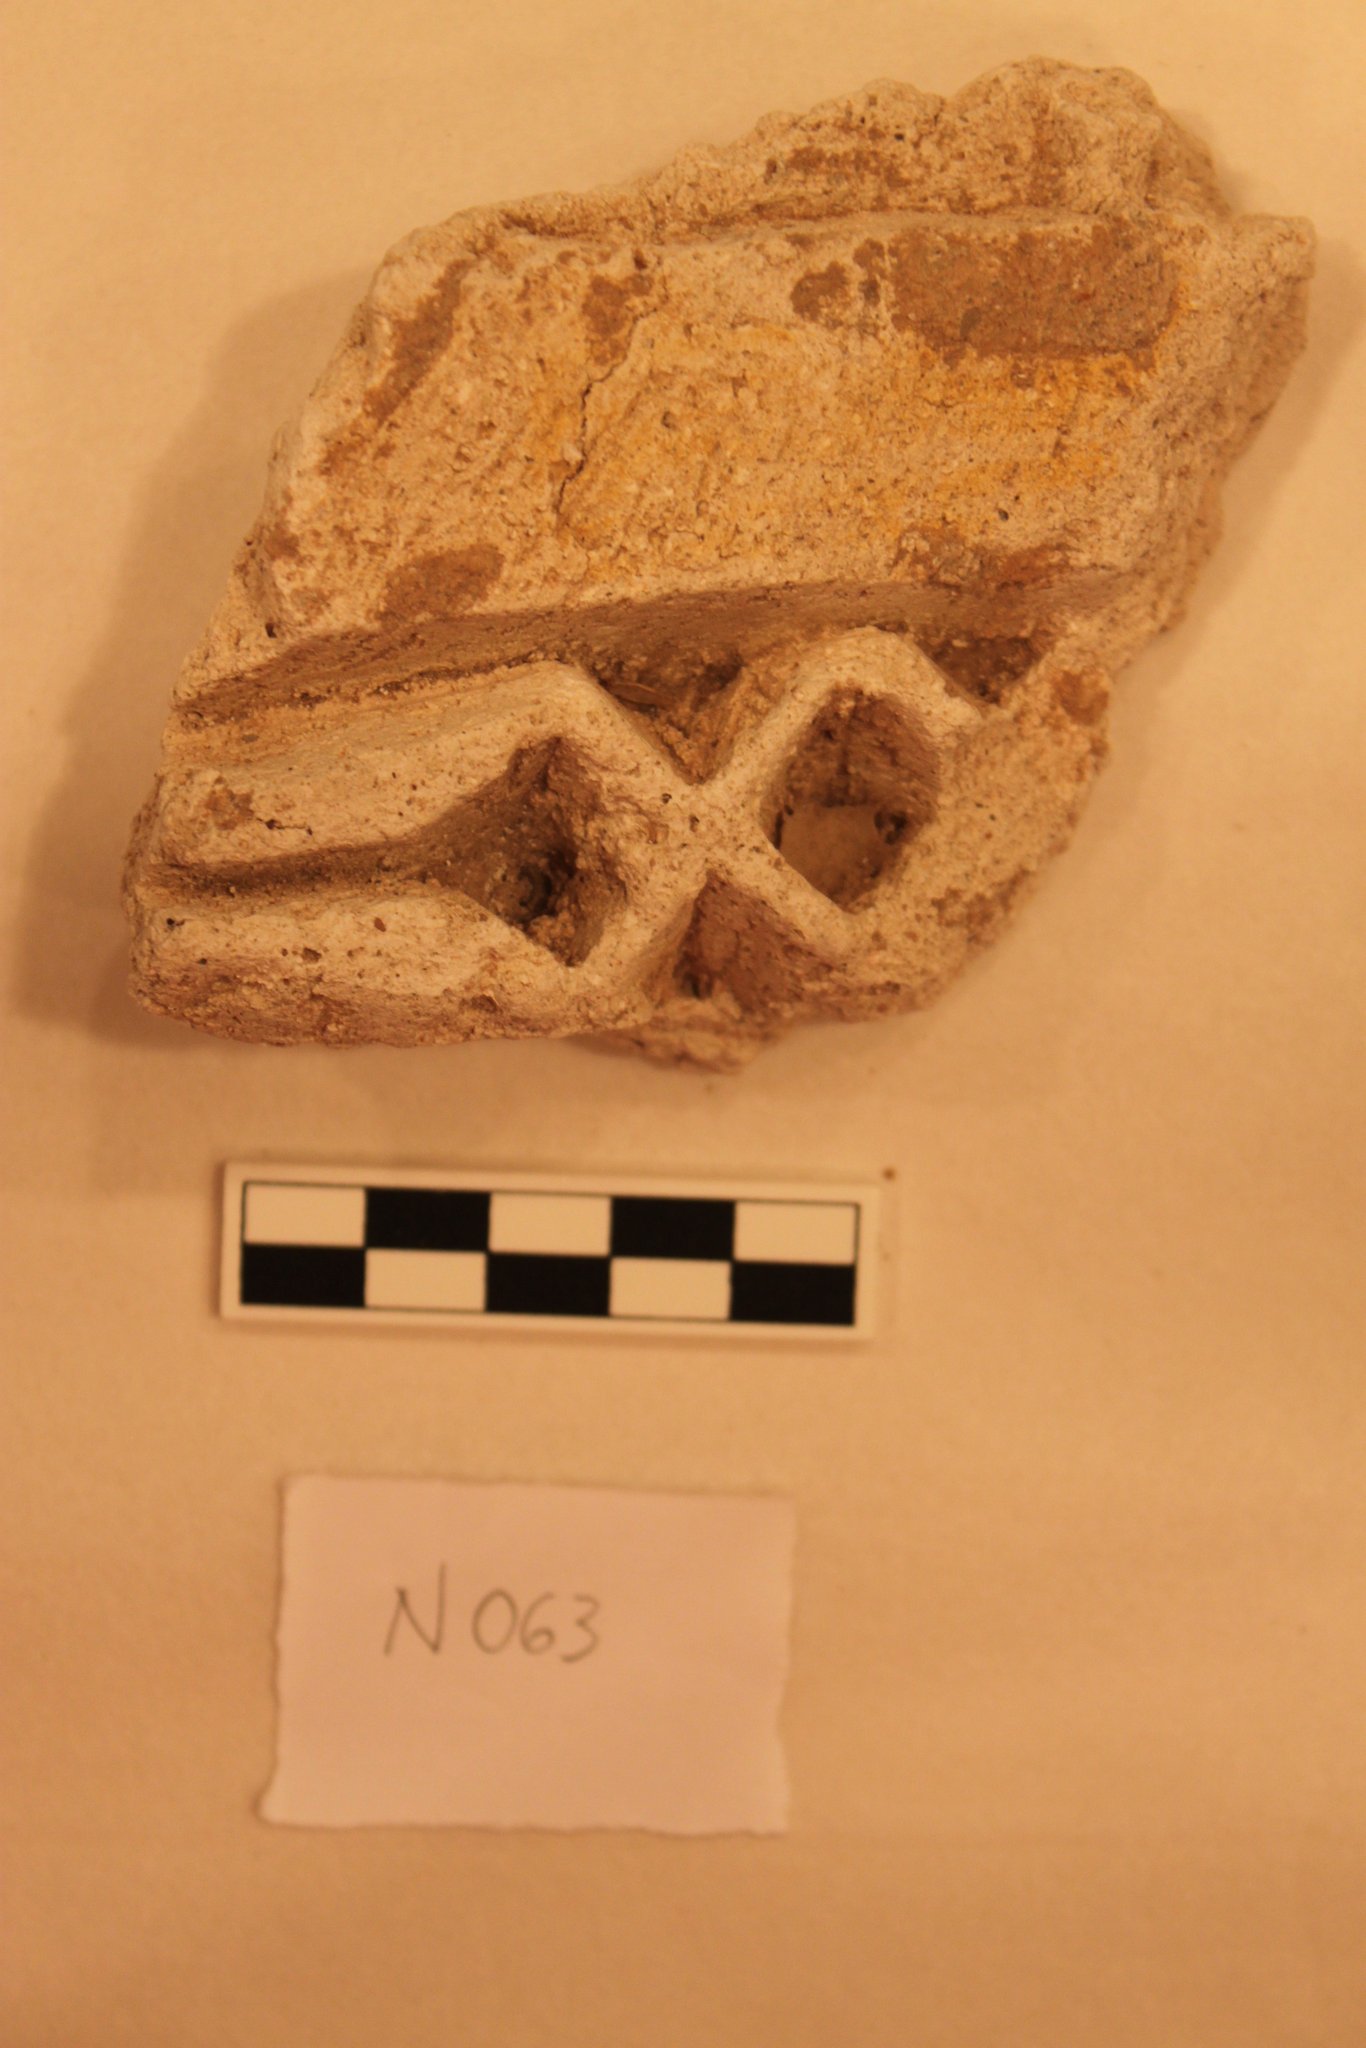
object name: fragment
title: Stucco Fragment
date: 701-1200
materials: plaster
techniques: carving, painting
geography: iran